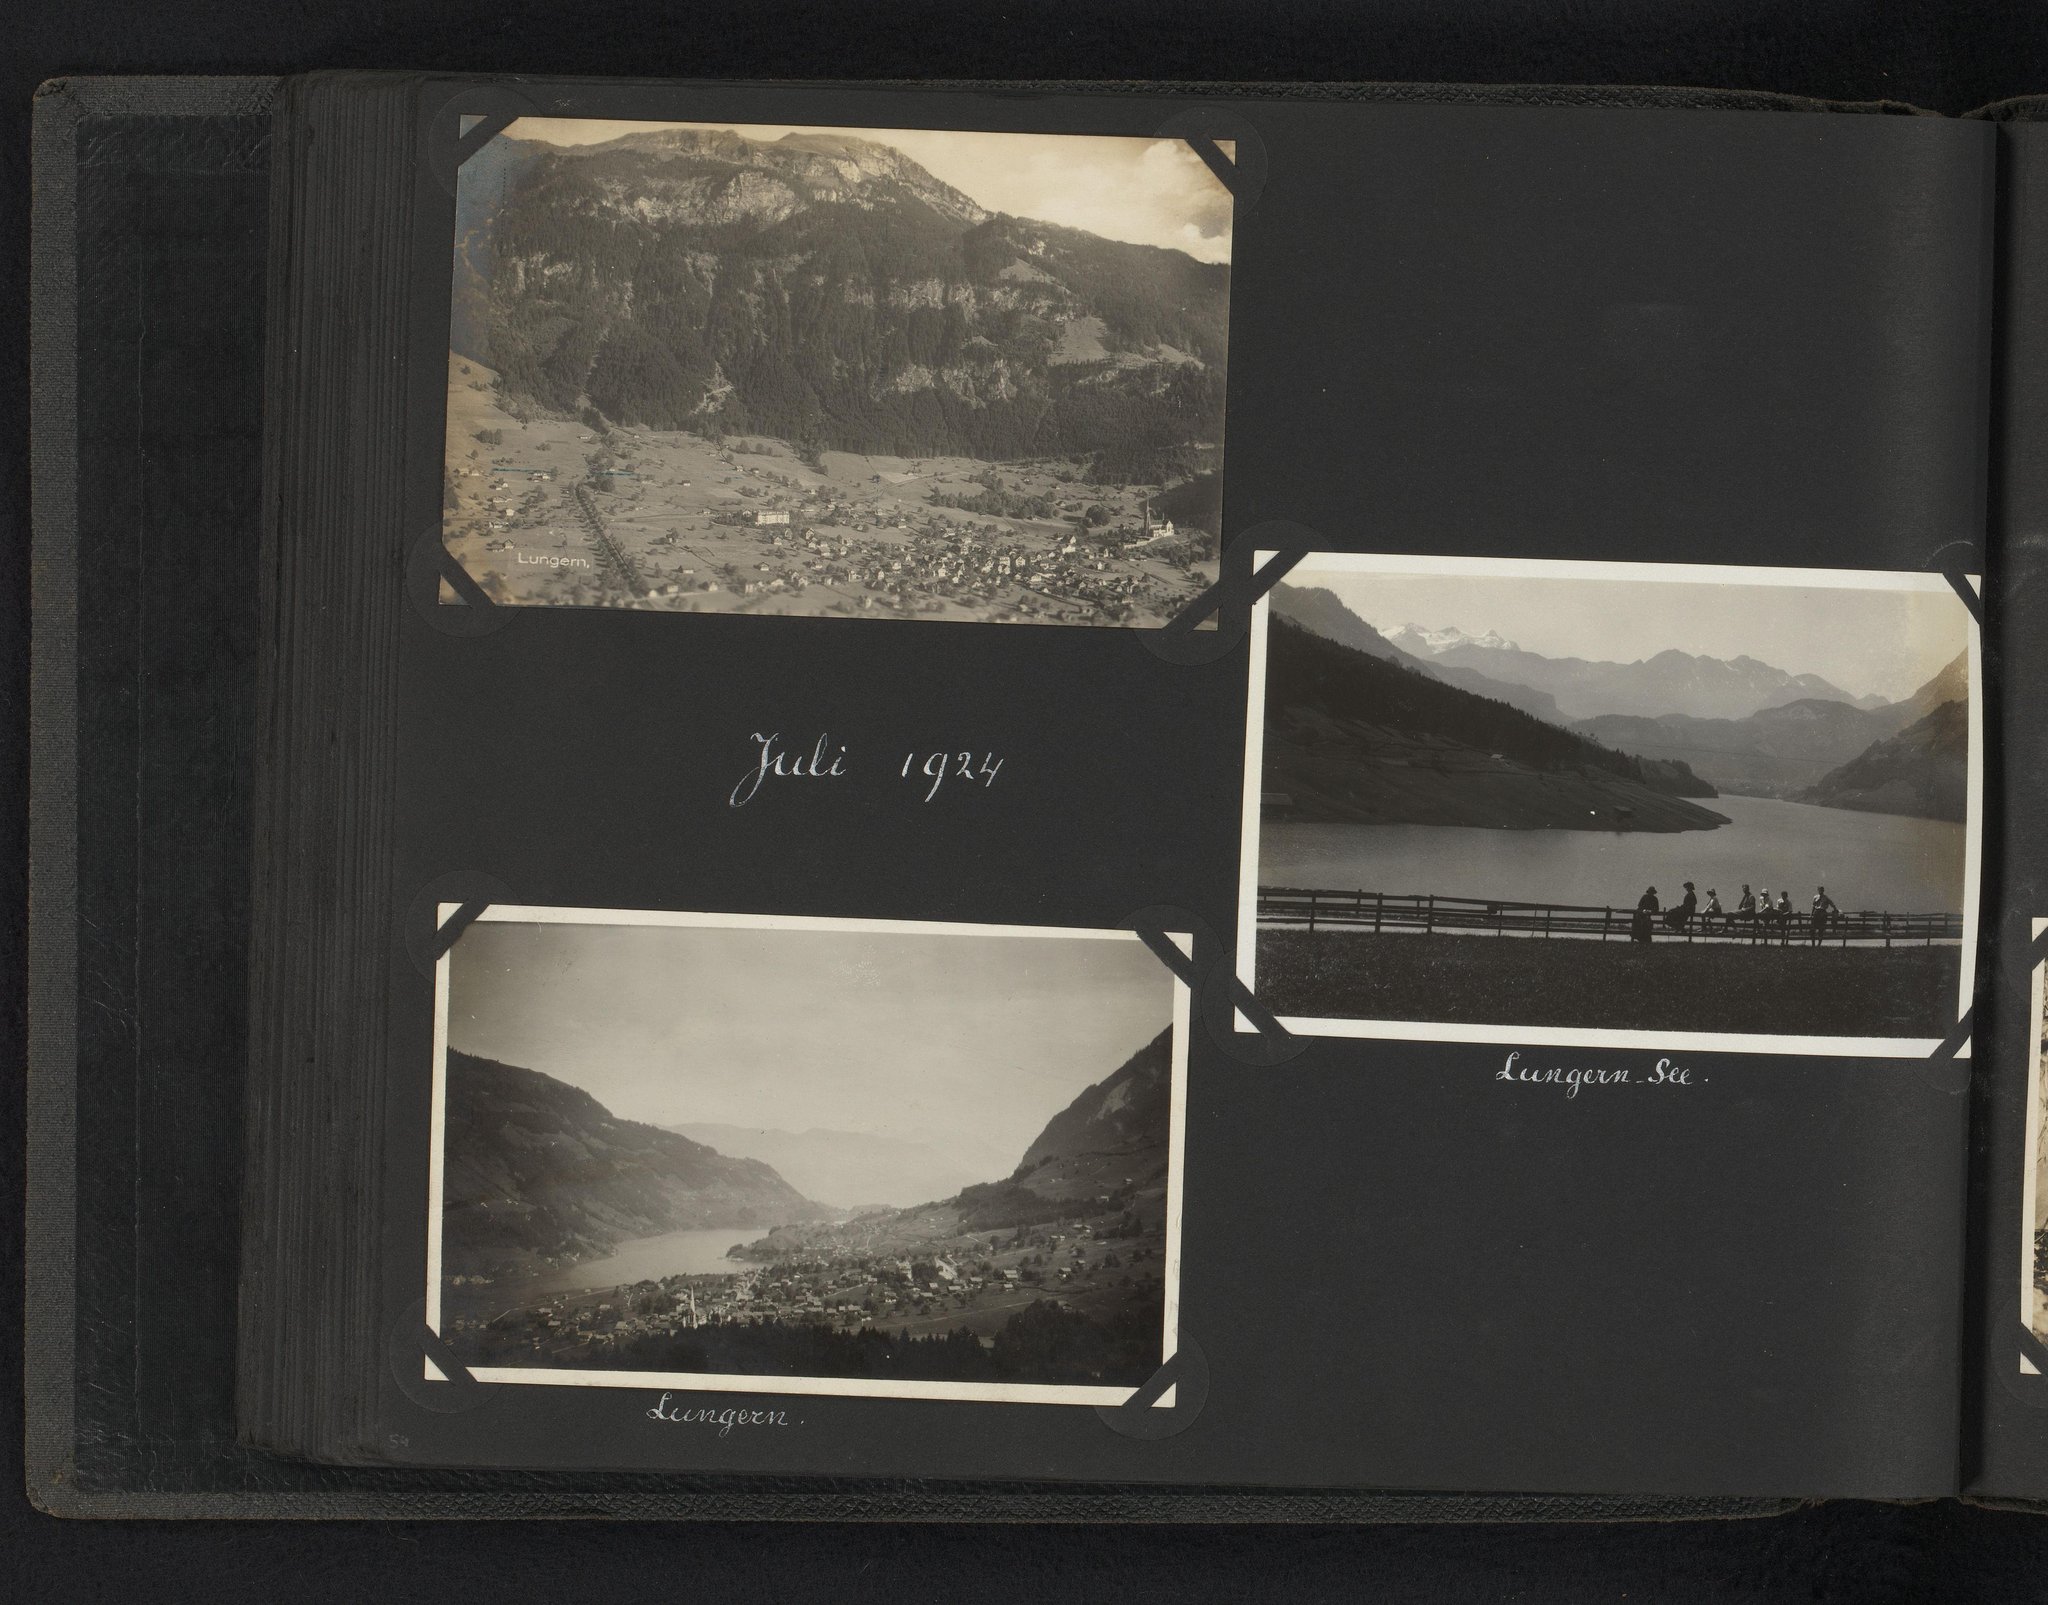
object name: album leaf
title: Drie foto's, waarvan een prentbriefkaart, van Lungern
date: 1907-1924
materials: paper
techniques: gelatin silver print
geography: obwalden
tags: village, lake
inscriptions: inscription: ‘Lungern See’, inscription: ‘Lungern’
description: Deze foto's maken deel uit van een album.